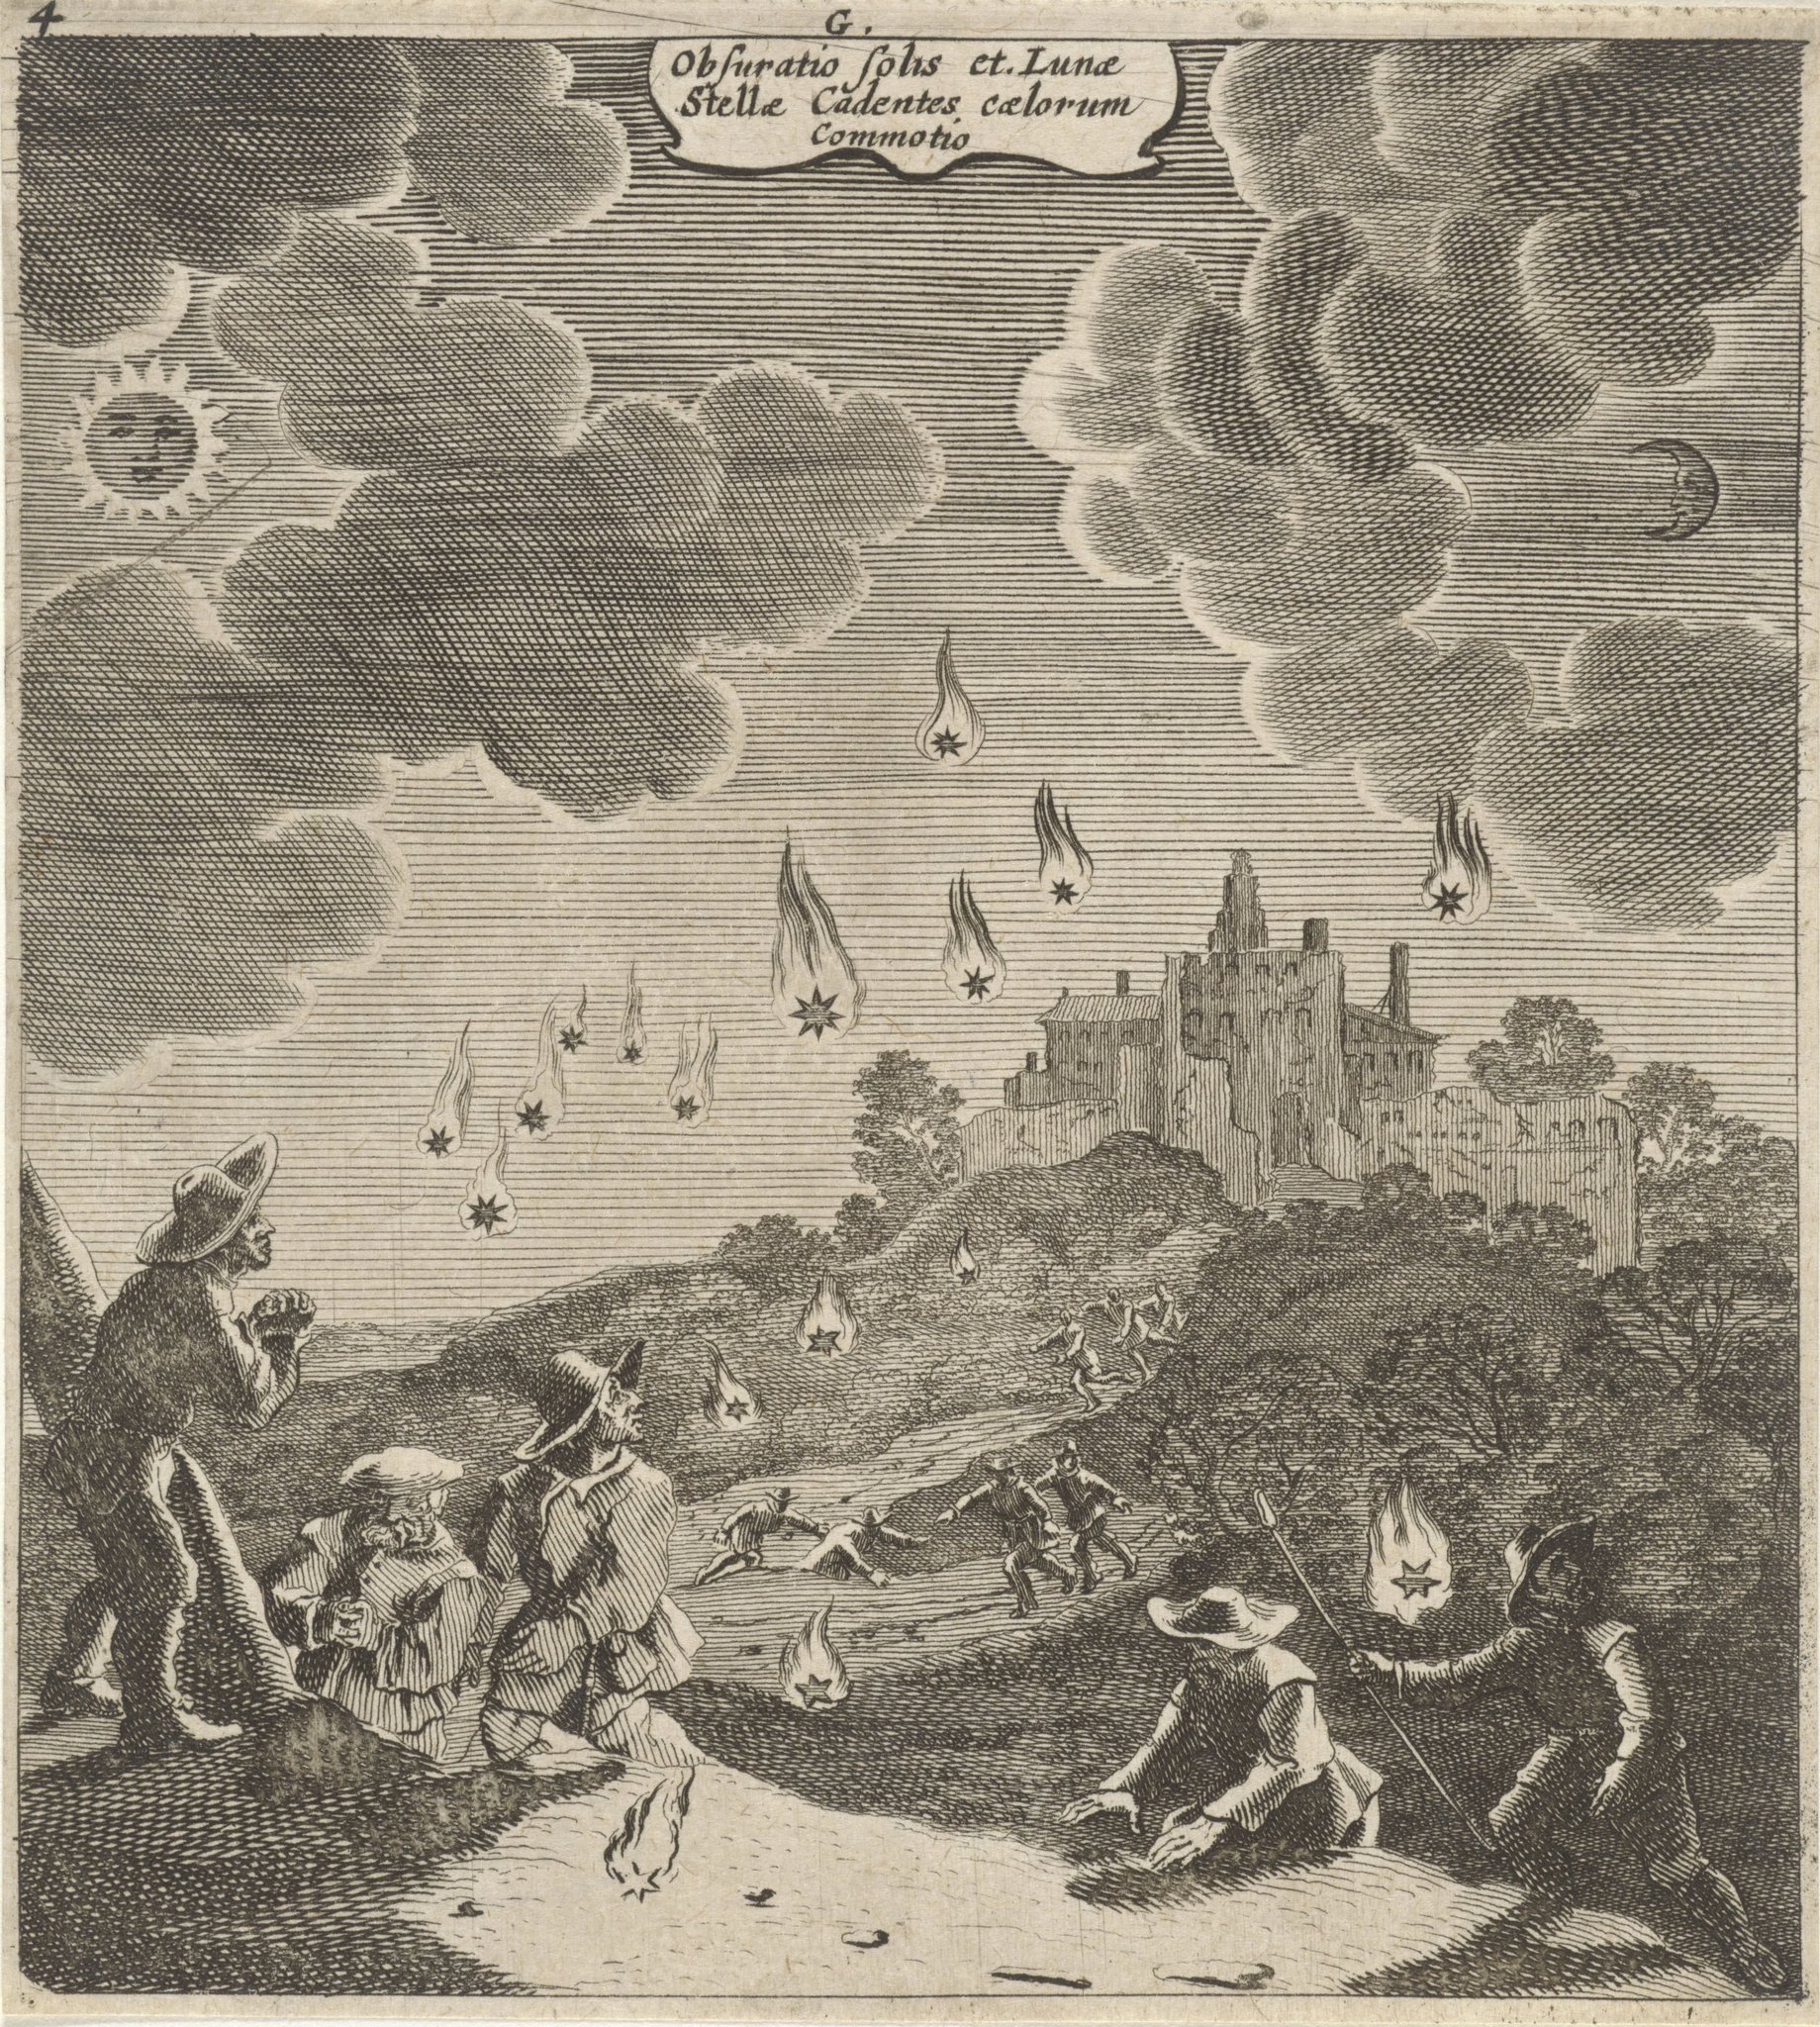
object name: book illustration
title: Obsuratio solis et Lunae Stelle Cadentes coelorum commotio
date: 1625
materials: paper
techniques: engraving, etching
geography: haarlem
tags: meteor, eclipse of the moon, solar eclipse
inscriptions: collector's mark: Lugt 2228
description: Heuvellandschap met biddende en in paniek zijnde mannen tijdens een zon- en maansverduistering. Uit de lucht vallen sterren. Op de achtergrond de ruines van een stad.